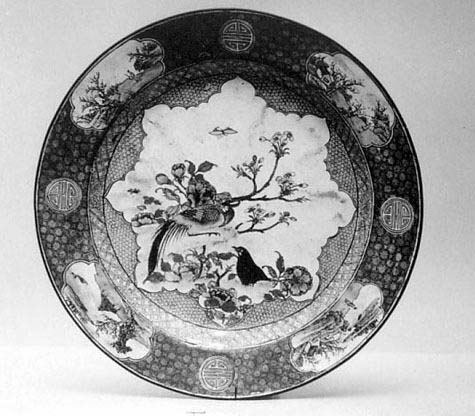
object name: plate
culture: chinese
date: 1736-1795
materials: enamel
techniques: painting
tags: birds,flowers,plants